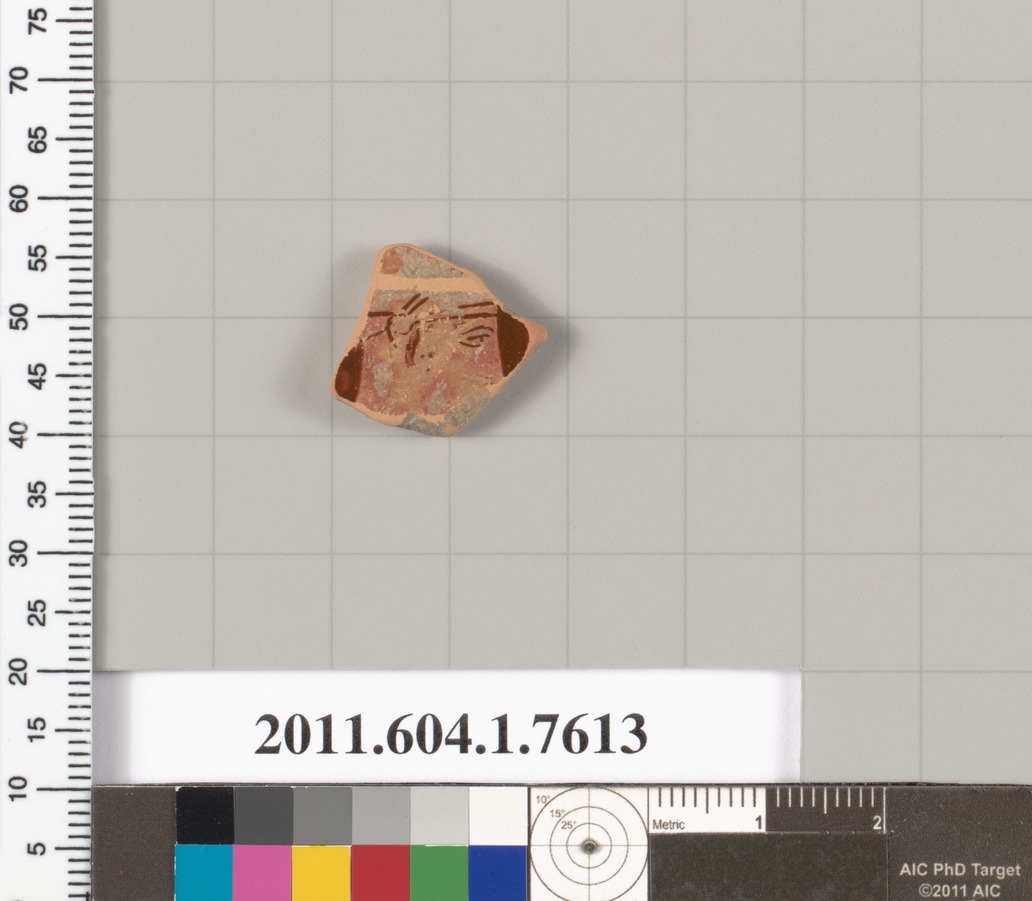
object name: kylix fragment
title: Terracotta fragment of a kylix (drinking cup)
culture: greek, attic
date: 460-450 BCE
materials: terracotta